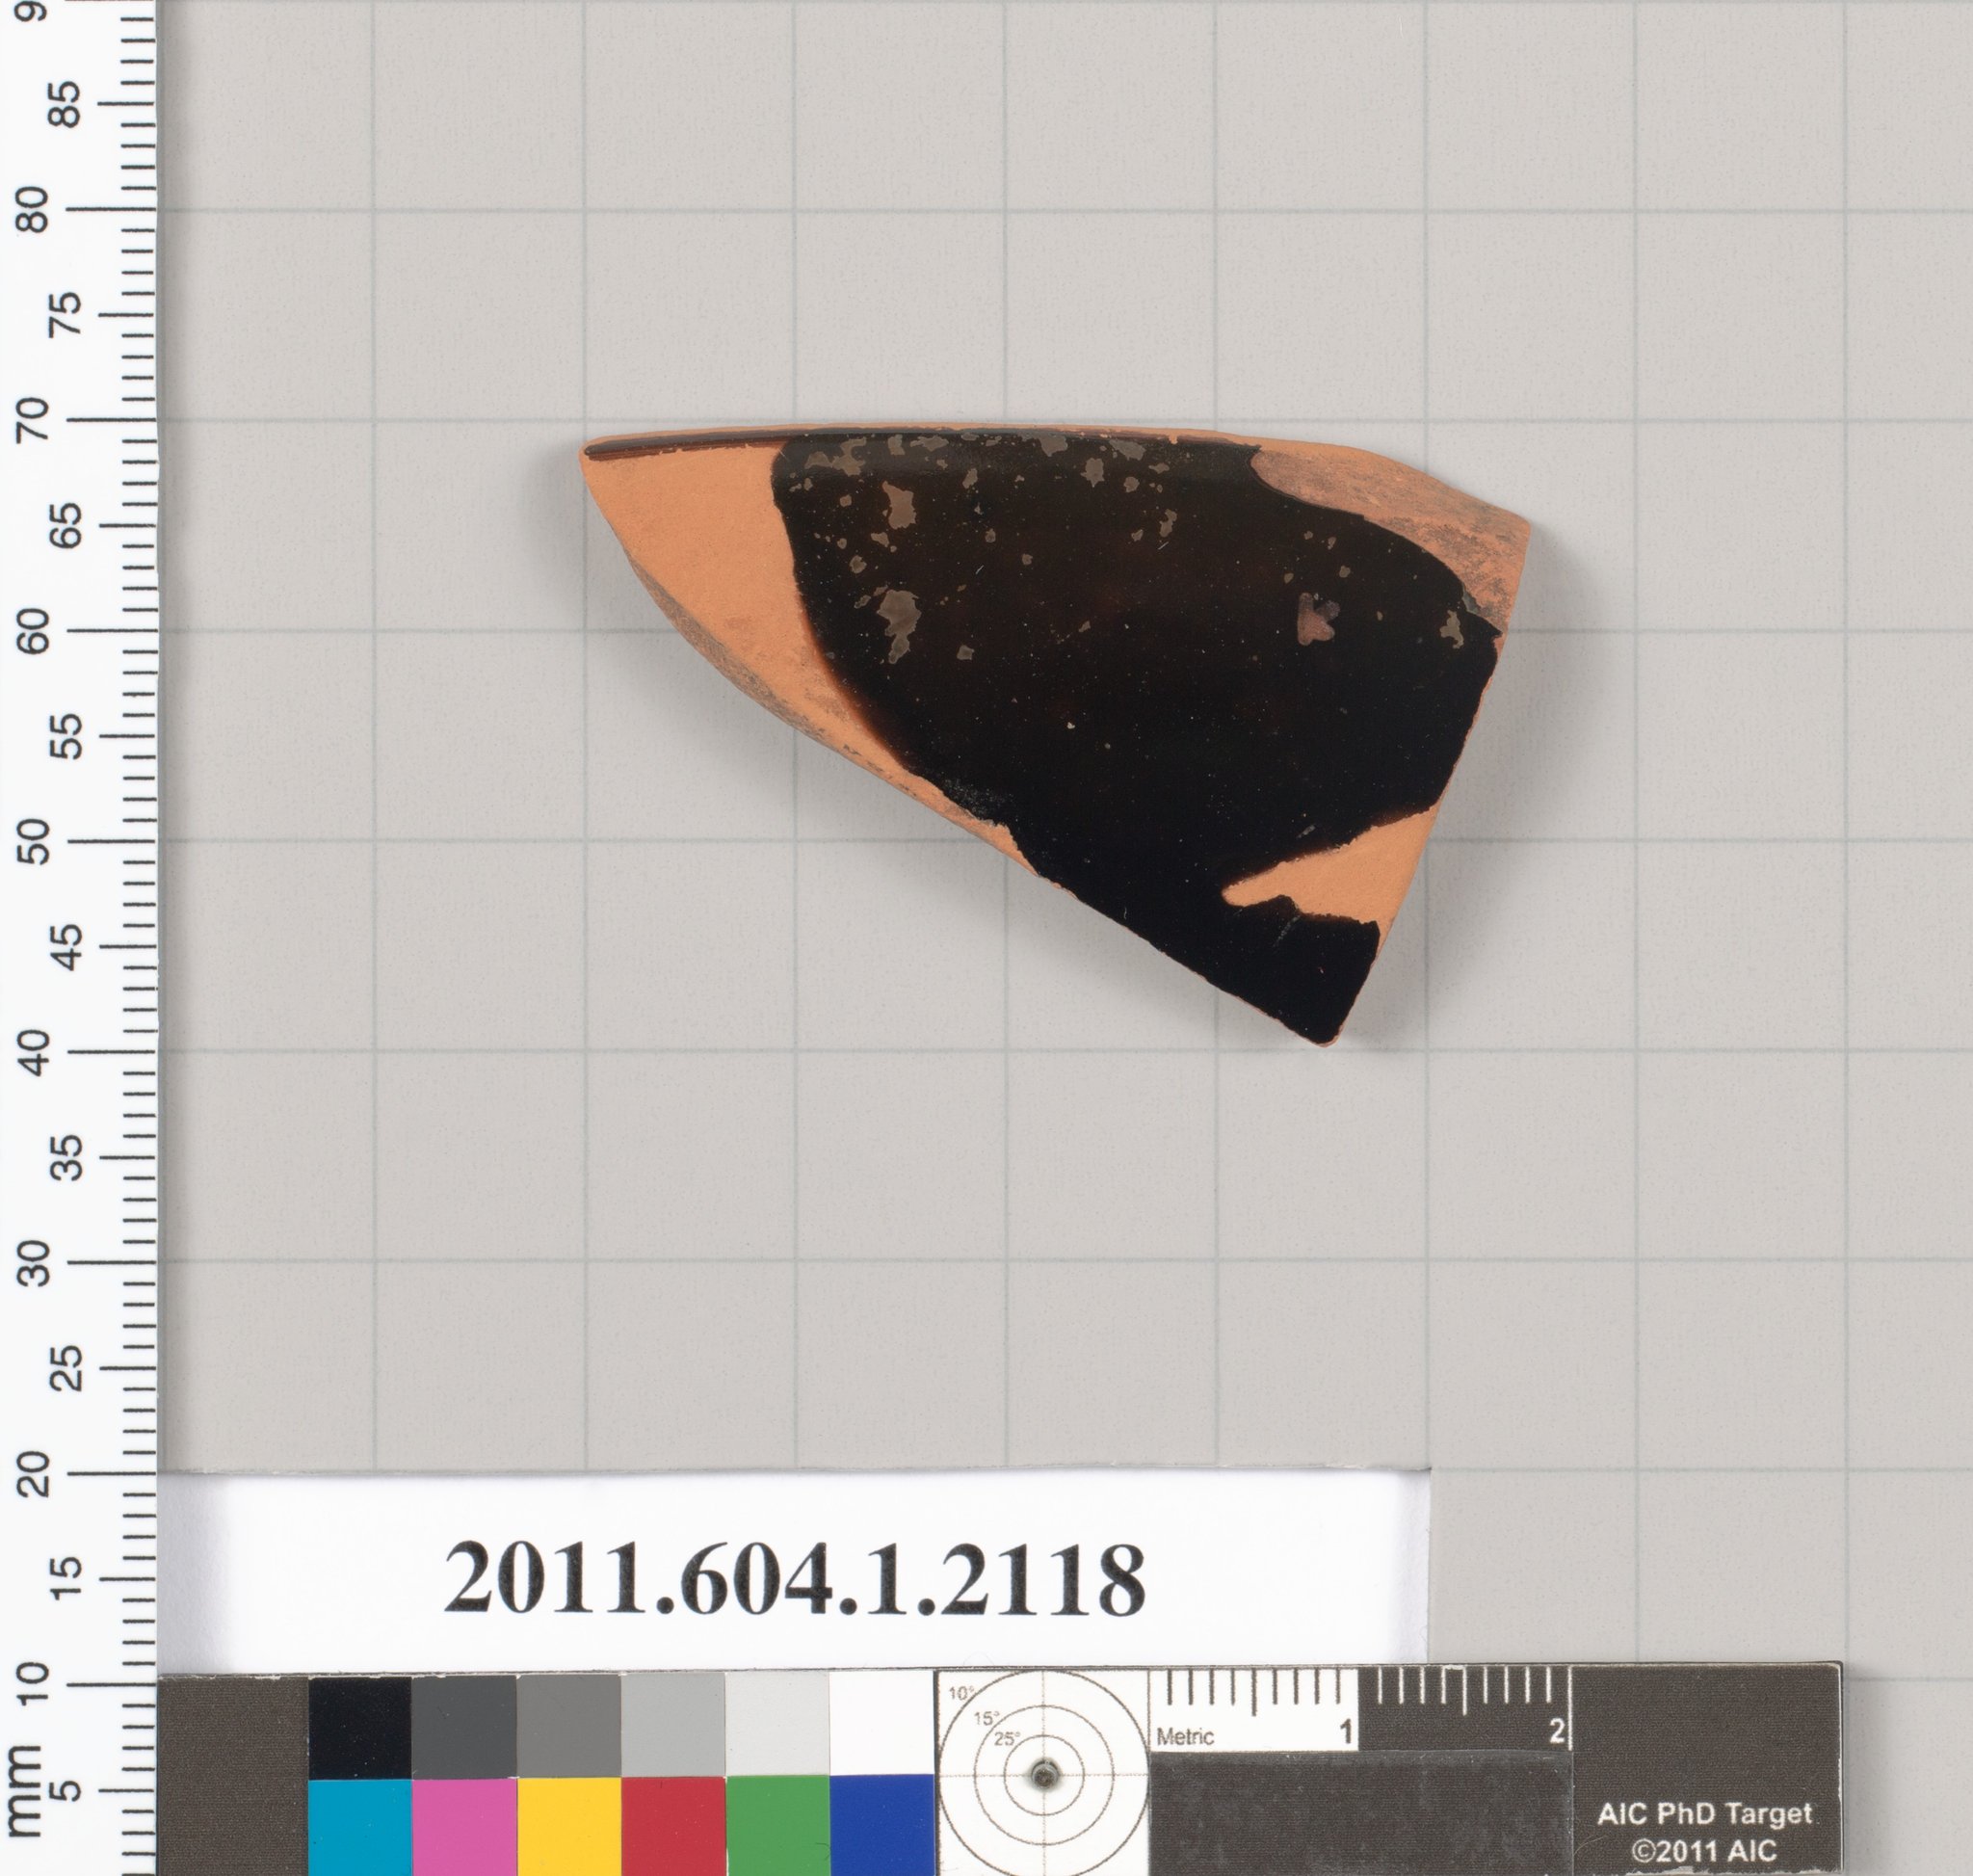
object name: kylix fragment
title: Terracotta rim fragment of a kylix (drinking cup)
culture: greek, attic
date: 500-401 BCE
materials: terracotta